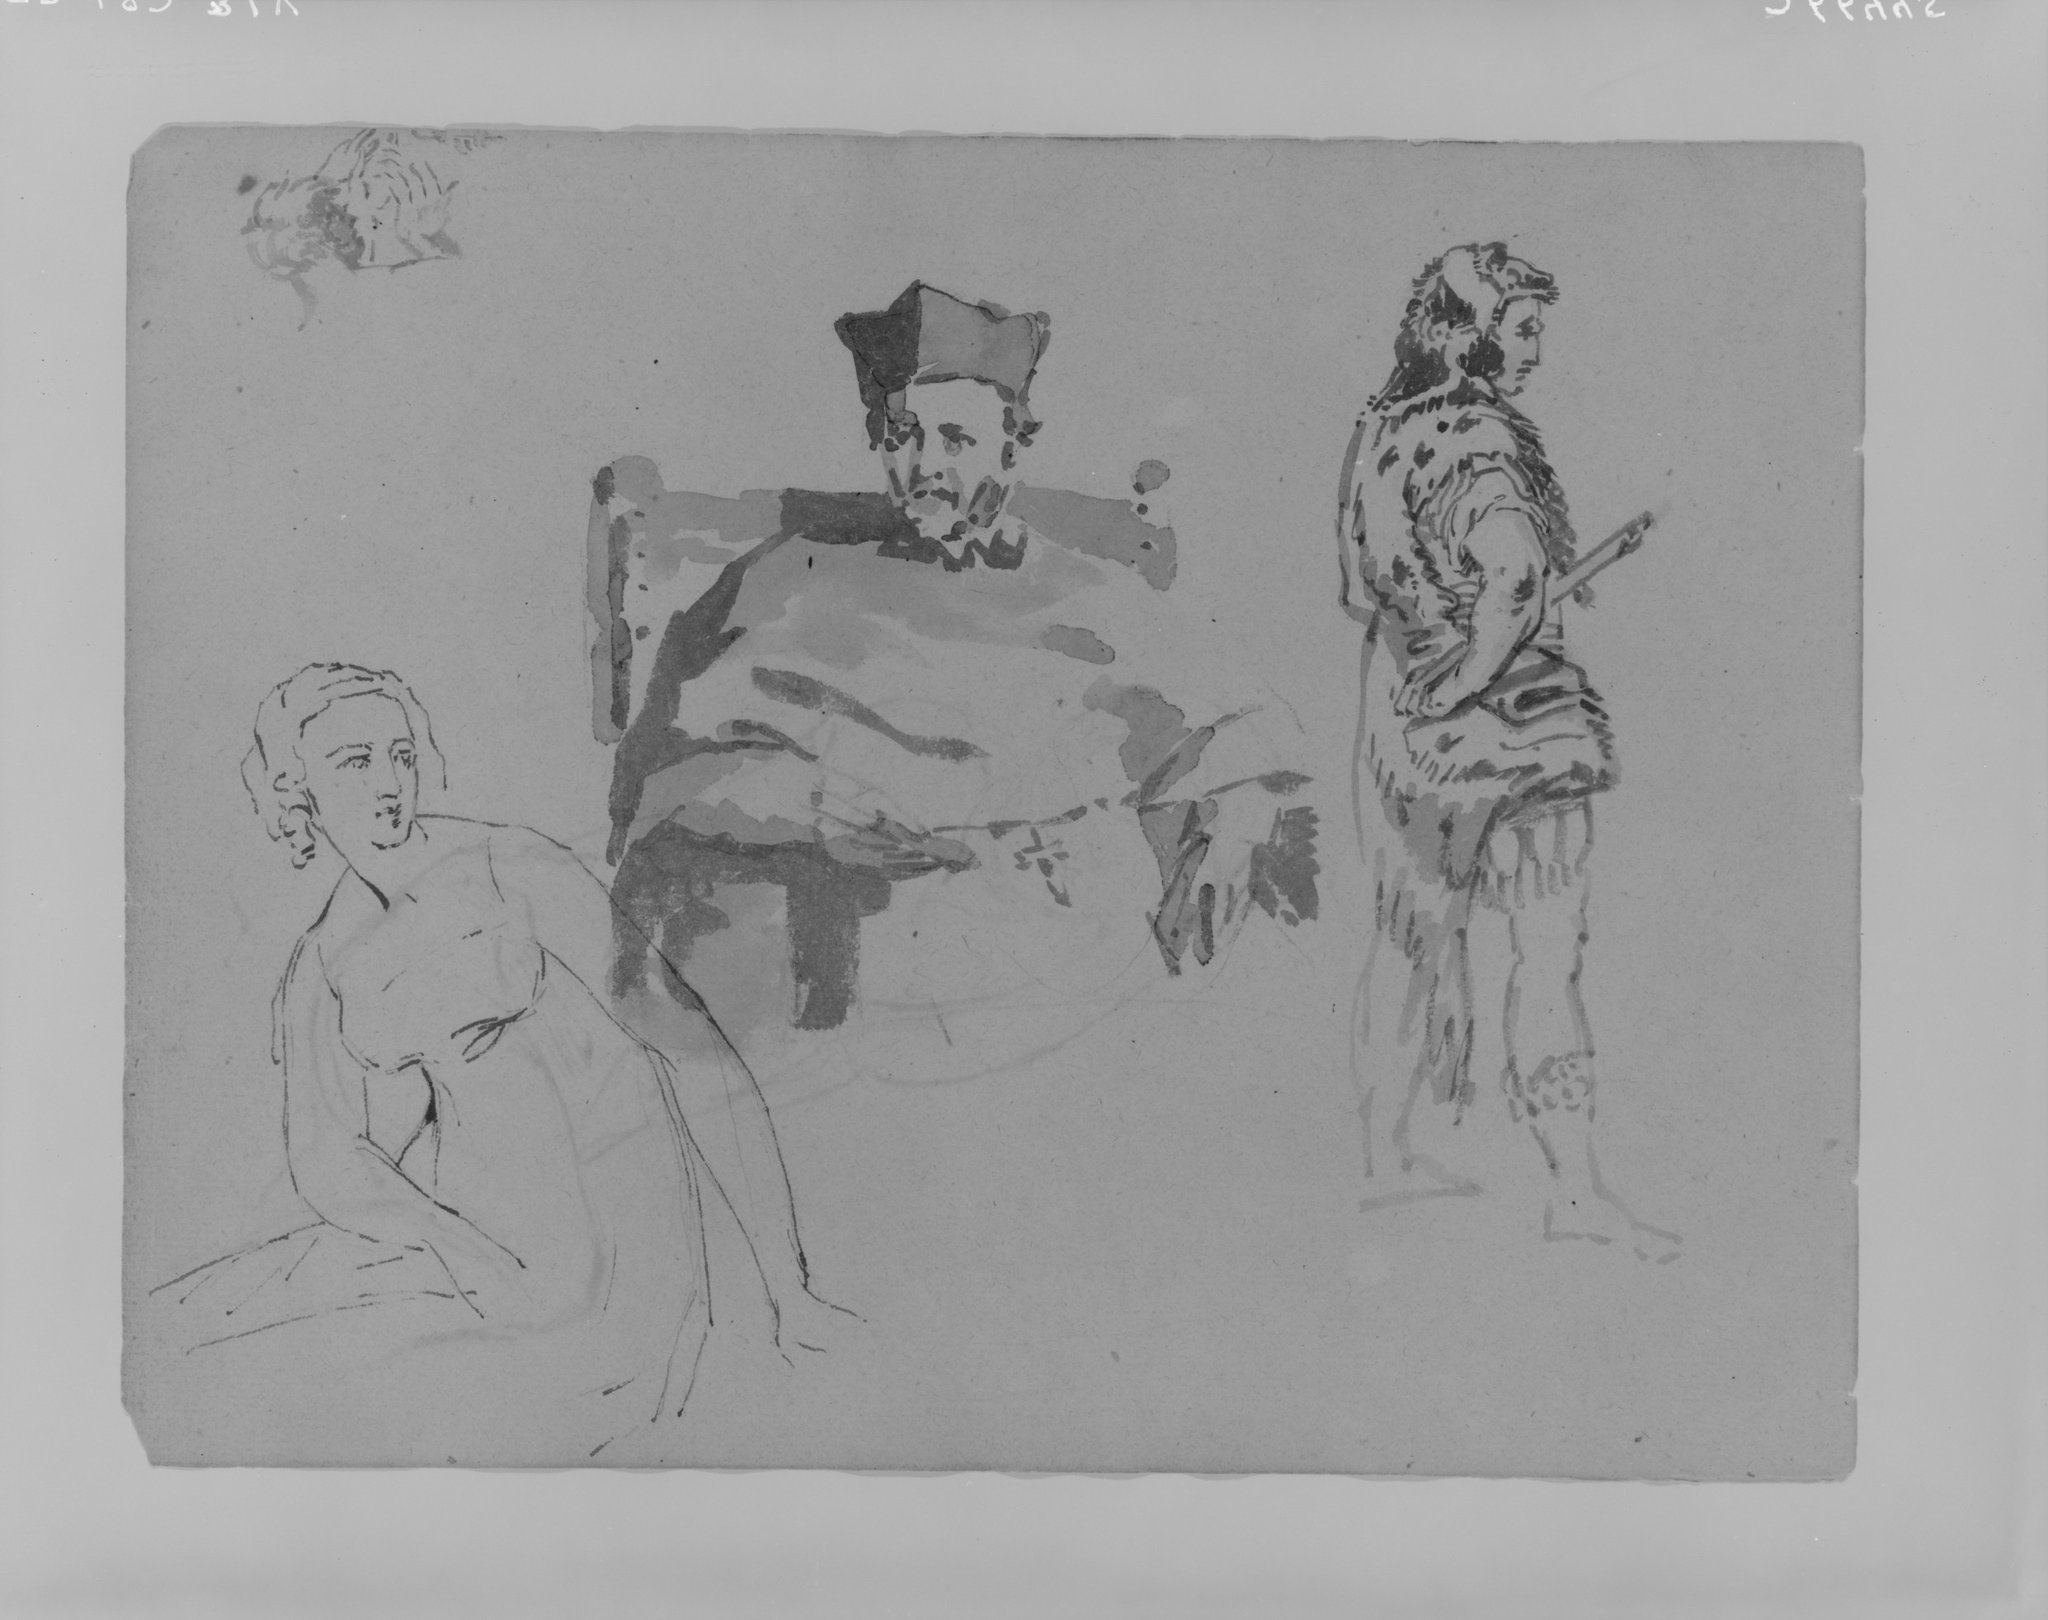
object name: drawing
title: (From Sketchbook)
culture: american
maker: thomas sully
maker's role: artist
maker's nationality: american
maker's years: 1783-1872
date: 1810-1820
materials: ink, paper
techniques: wash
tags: men,women